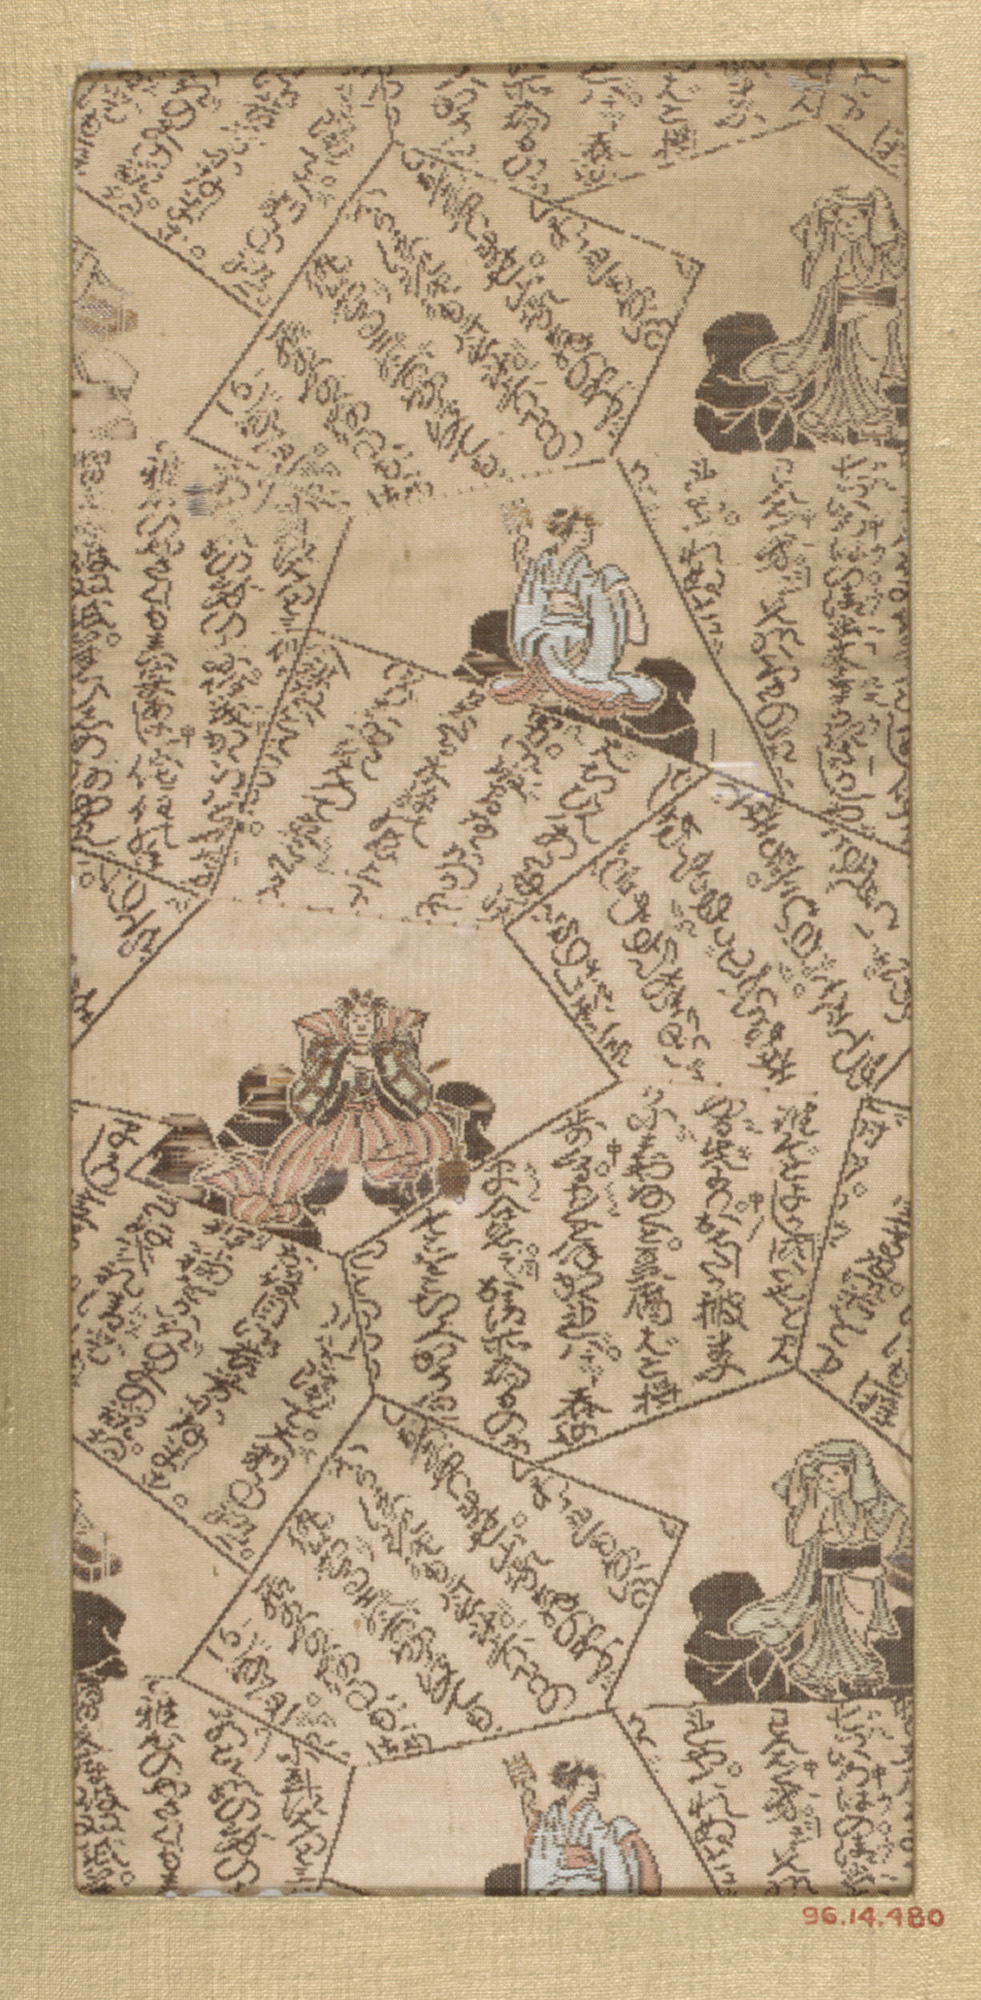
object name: fragment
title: Textile fragment with pattern of pages with script and bunraku puppeteers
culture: japanese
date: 1701-1900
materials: silk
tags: human figures